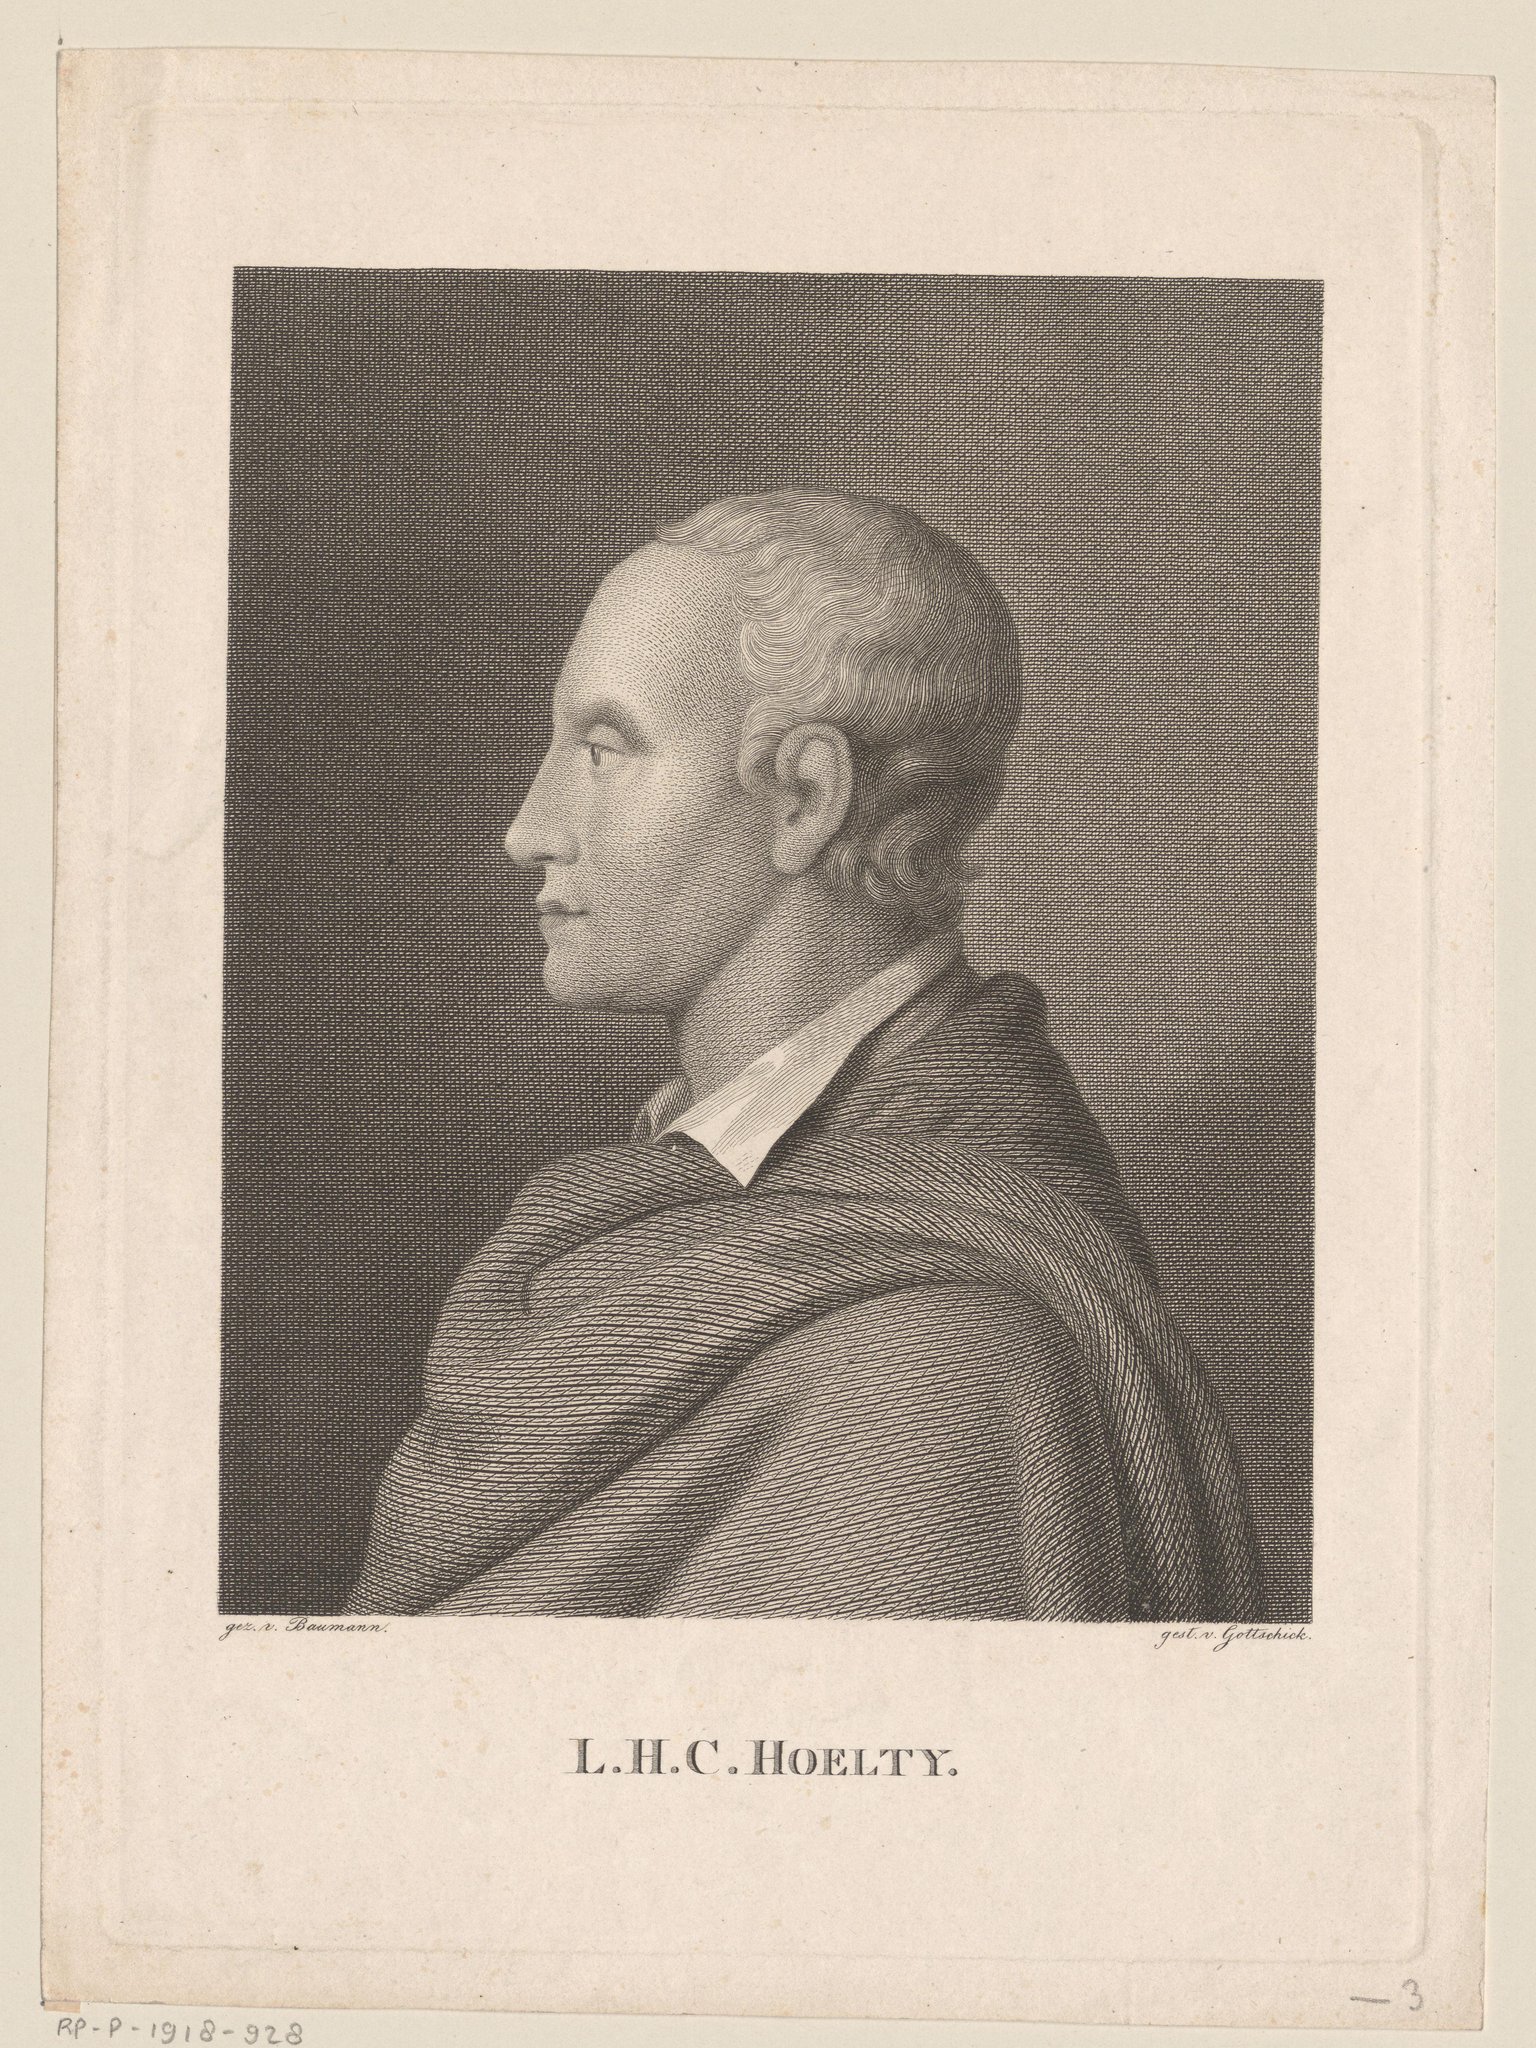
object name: print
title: Portret van Ludwig Hölty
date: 1786-1844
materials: paper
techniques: engraving, etching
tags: historical persons, writer, poet, author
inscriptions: collector's mark: Lugt 2233